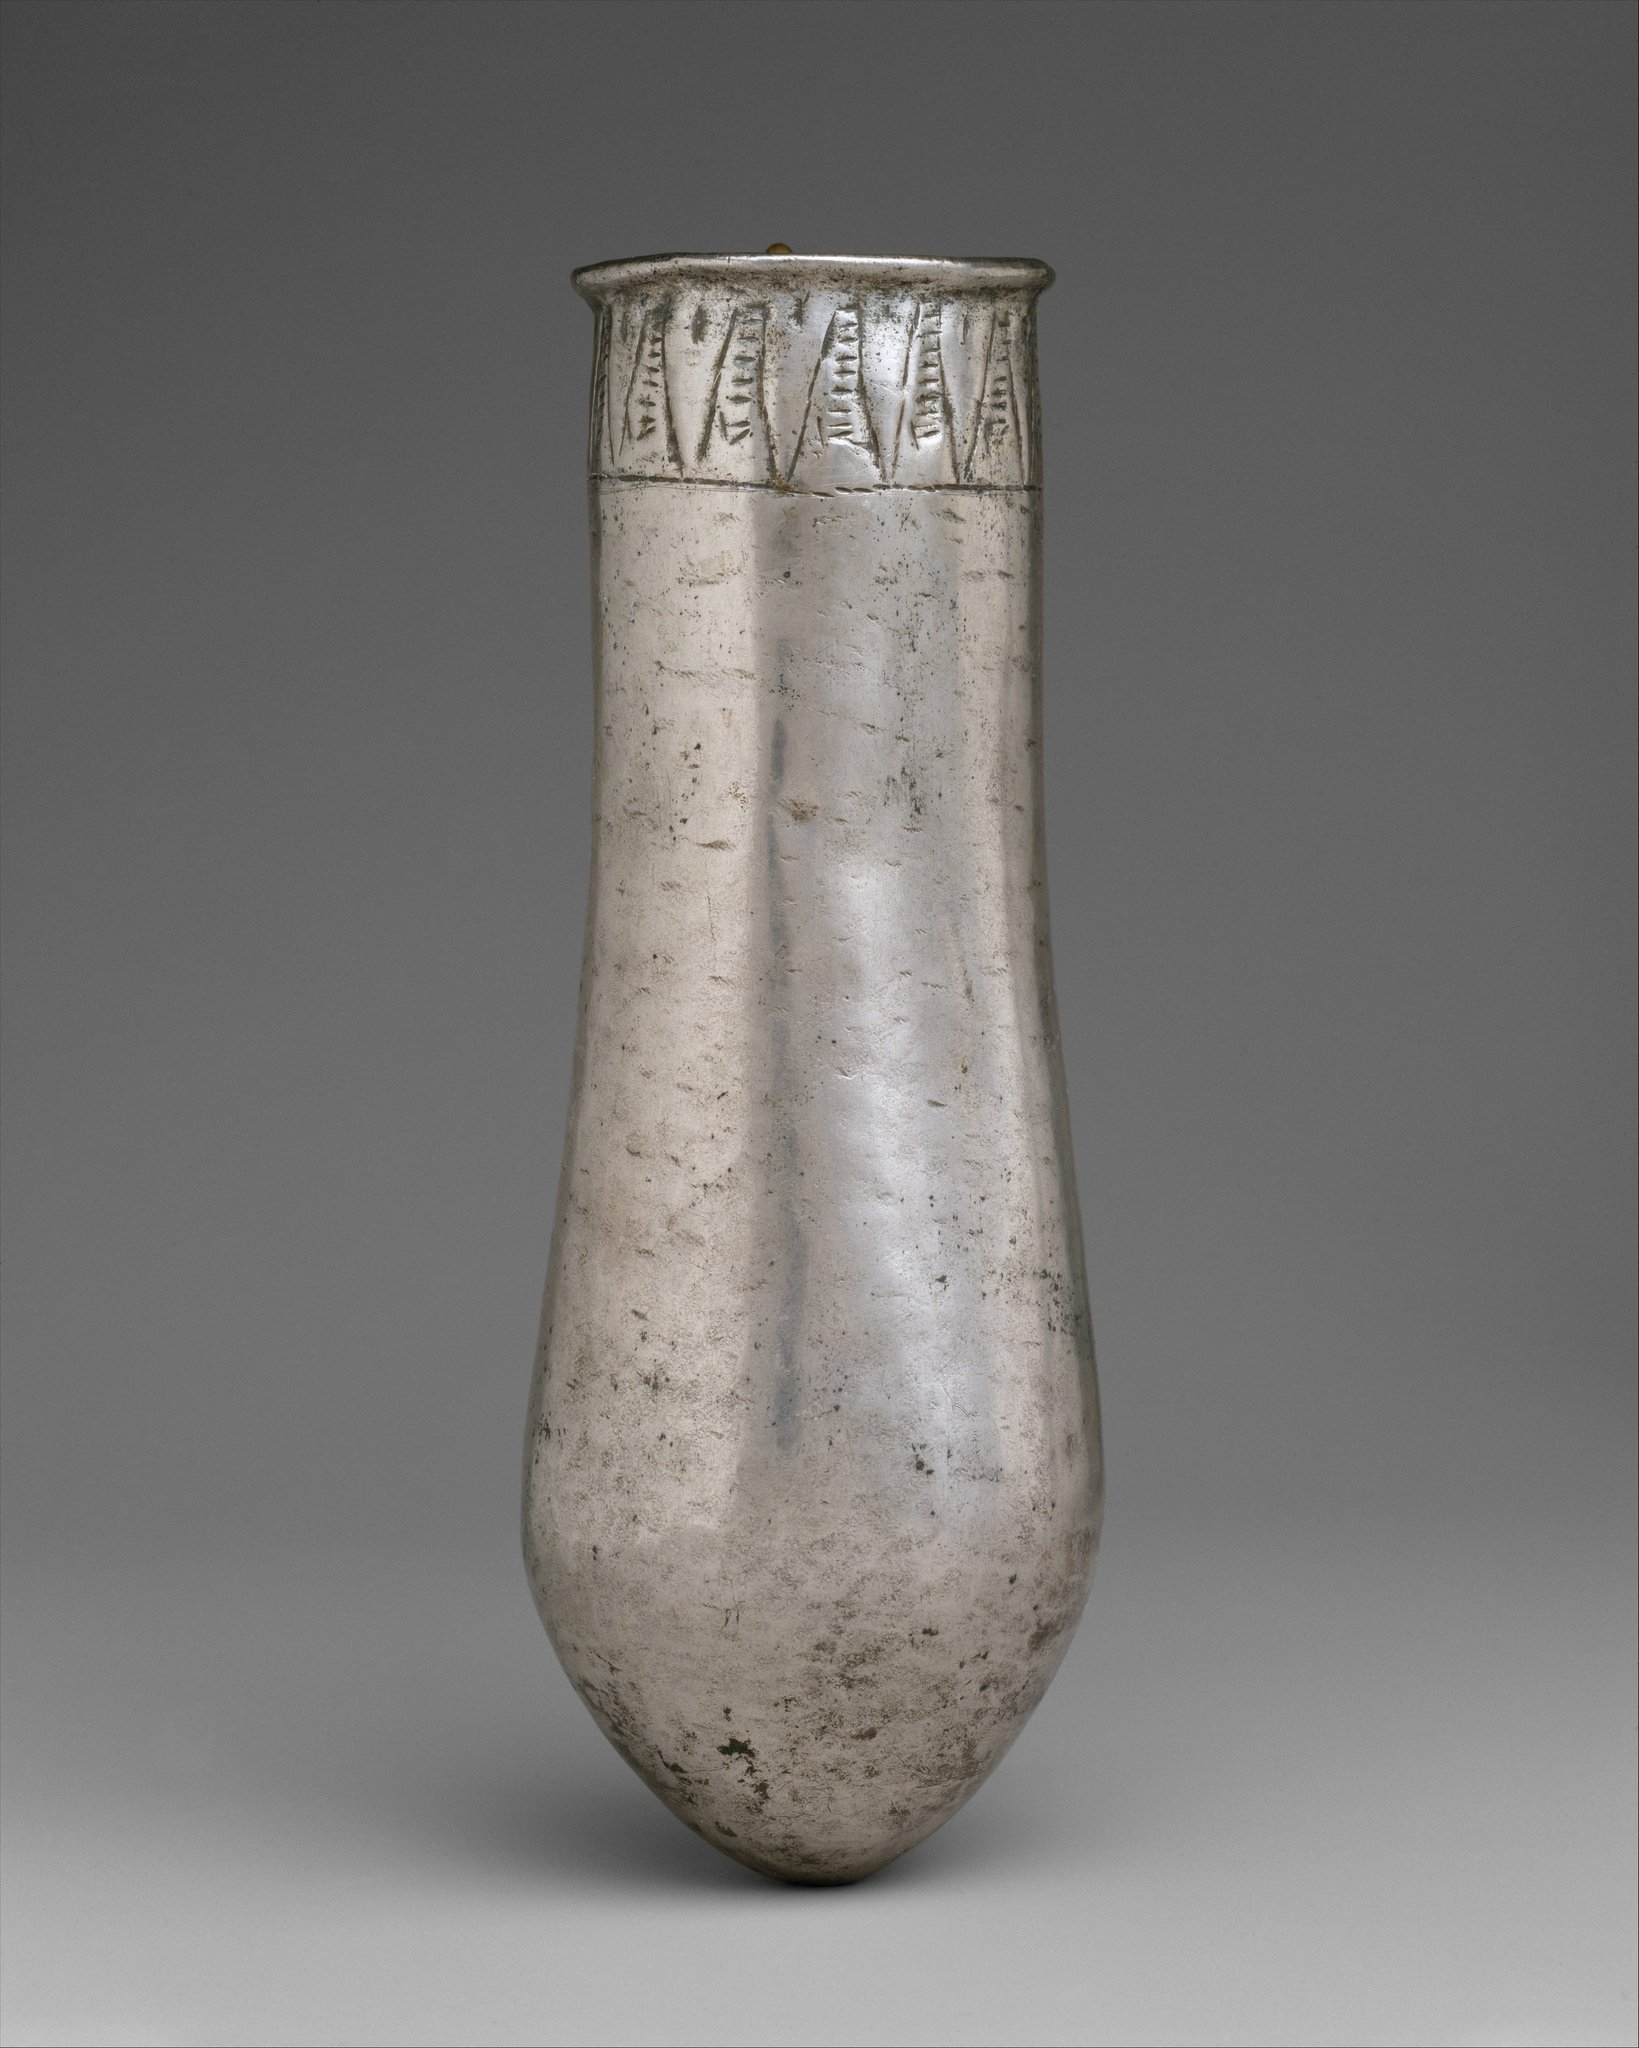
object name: situla, floral decoration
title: Situla with floral decoration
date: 1279-1213 BCE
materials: silver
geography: egypt